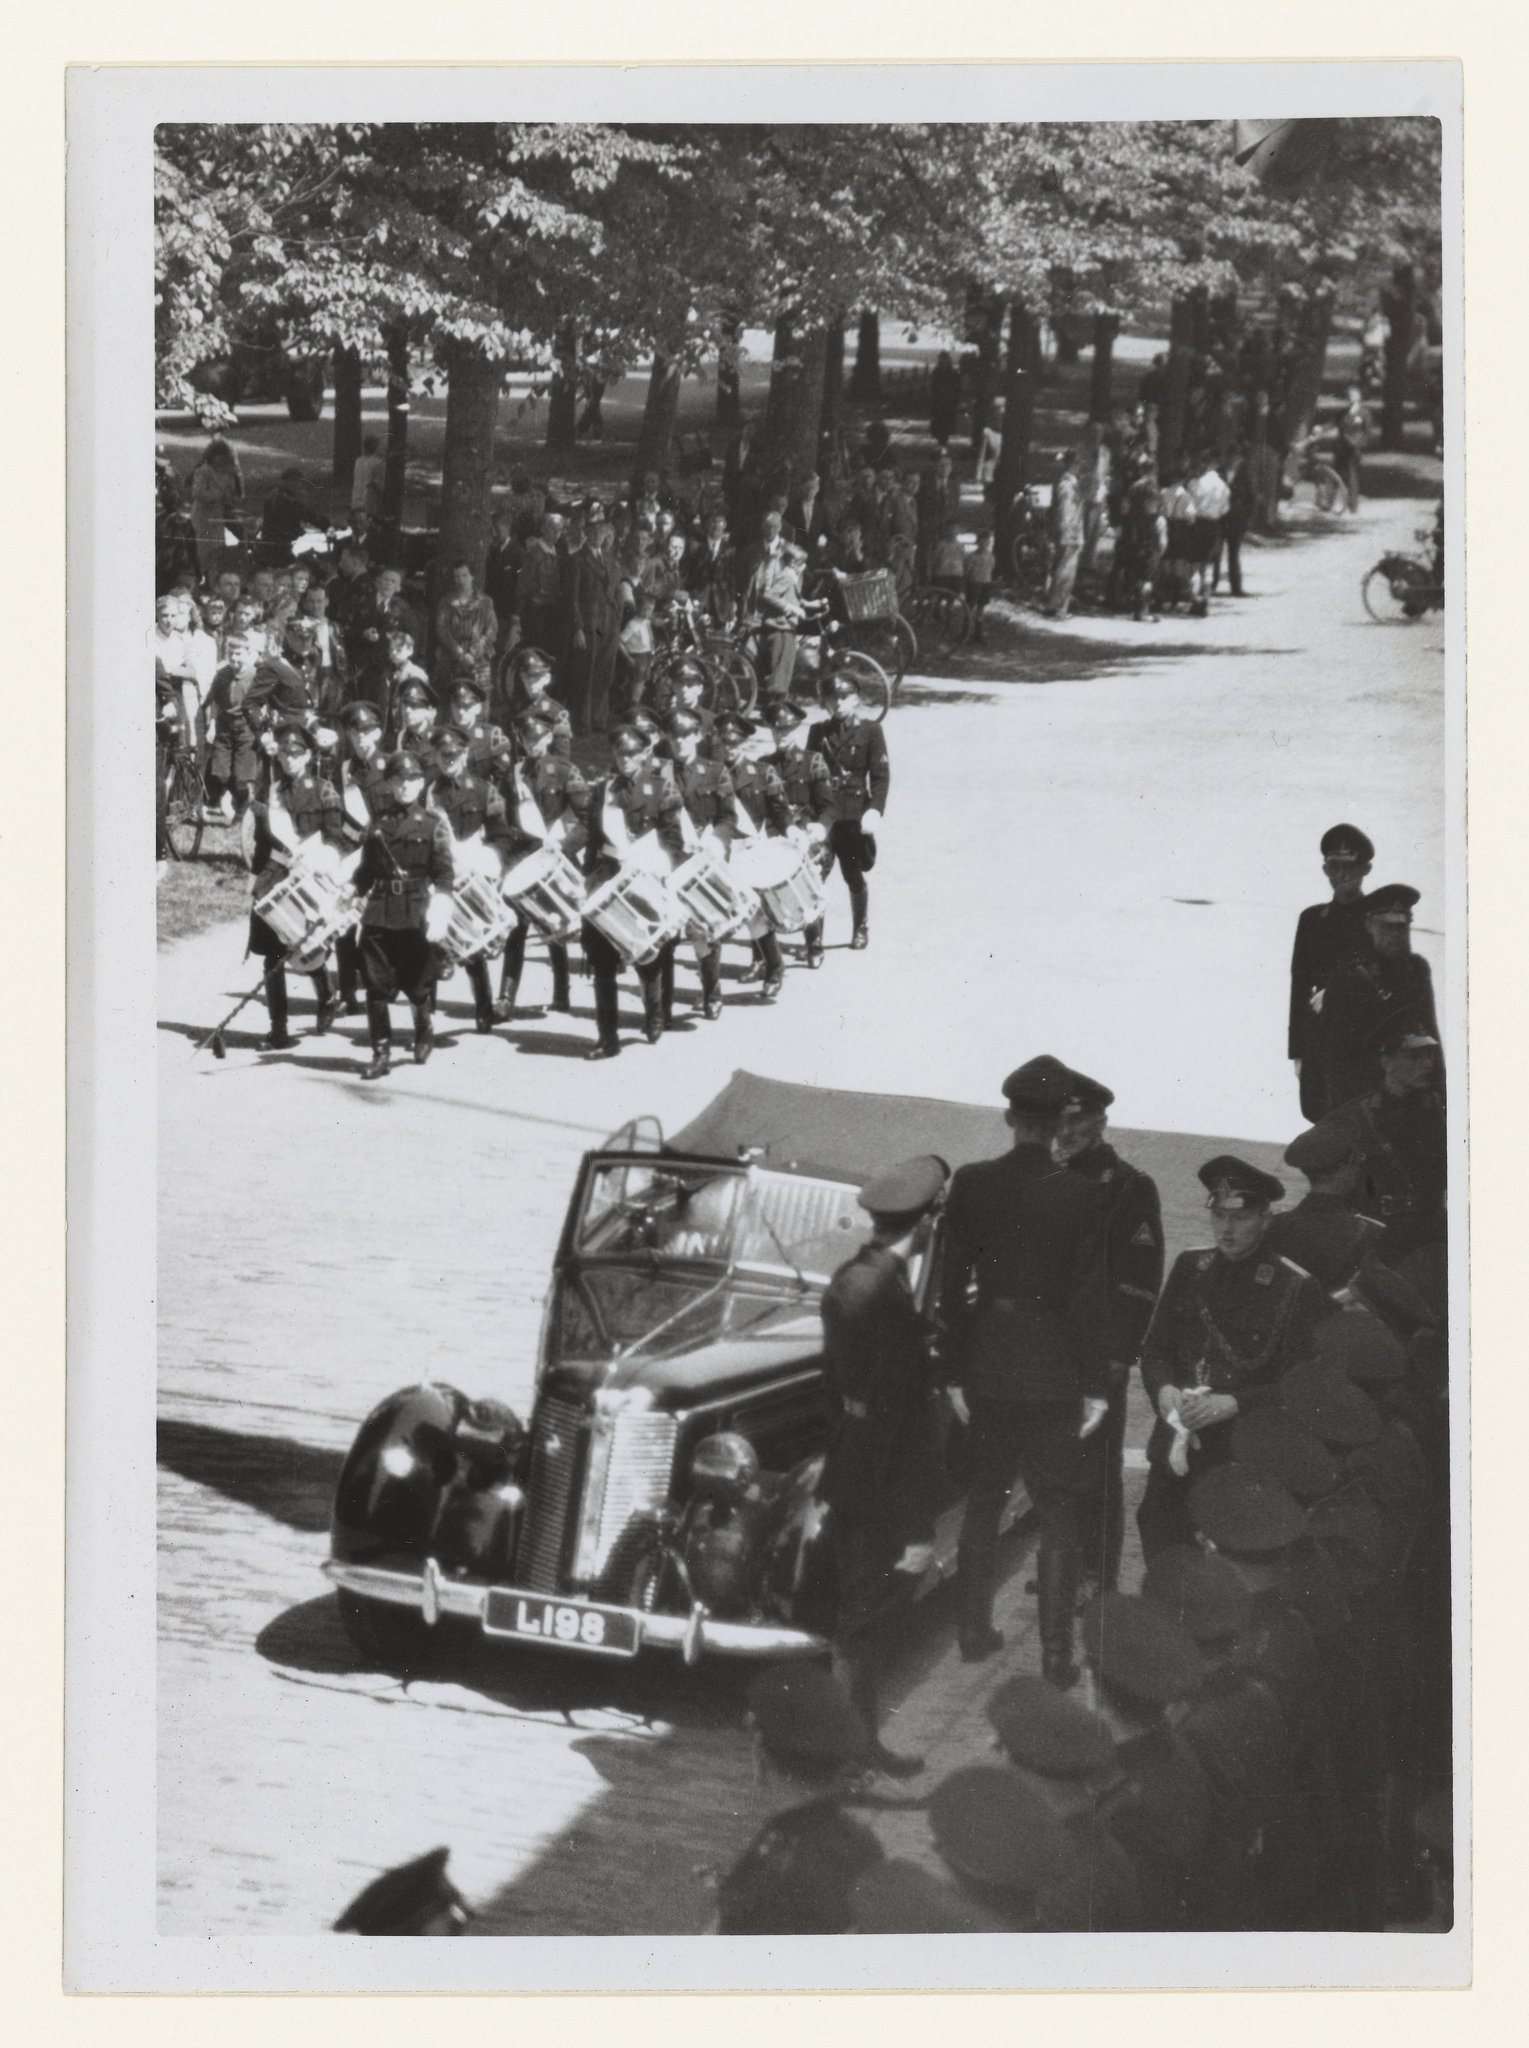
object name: photograph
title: Optocht NSB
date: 1940-1943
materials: photographic support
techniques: gelatin silver print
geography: netherlands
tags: military parade, pageant, netherlands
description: Optocht van de NSB (misschien WA) door een laan met bomen. Rechts mannen in zwart uniform bij een auto, (met nummerbord L198, de auto van A. Mussert?). De stoet mannen in zwarte uniformen links dragen bijna allemaal trommels. Langs de kant onder de bomen staan enkele toeschouwers.